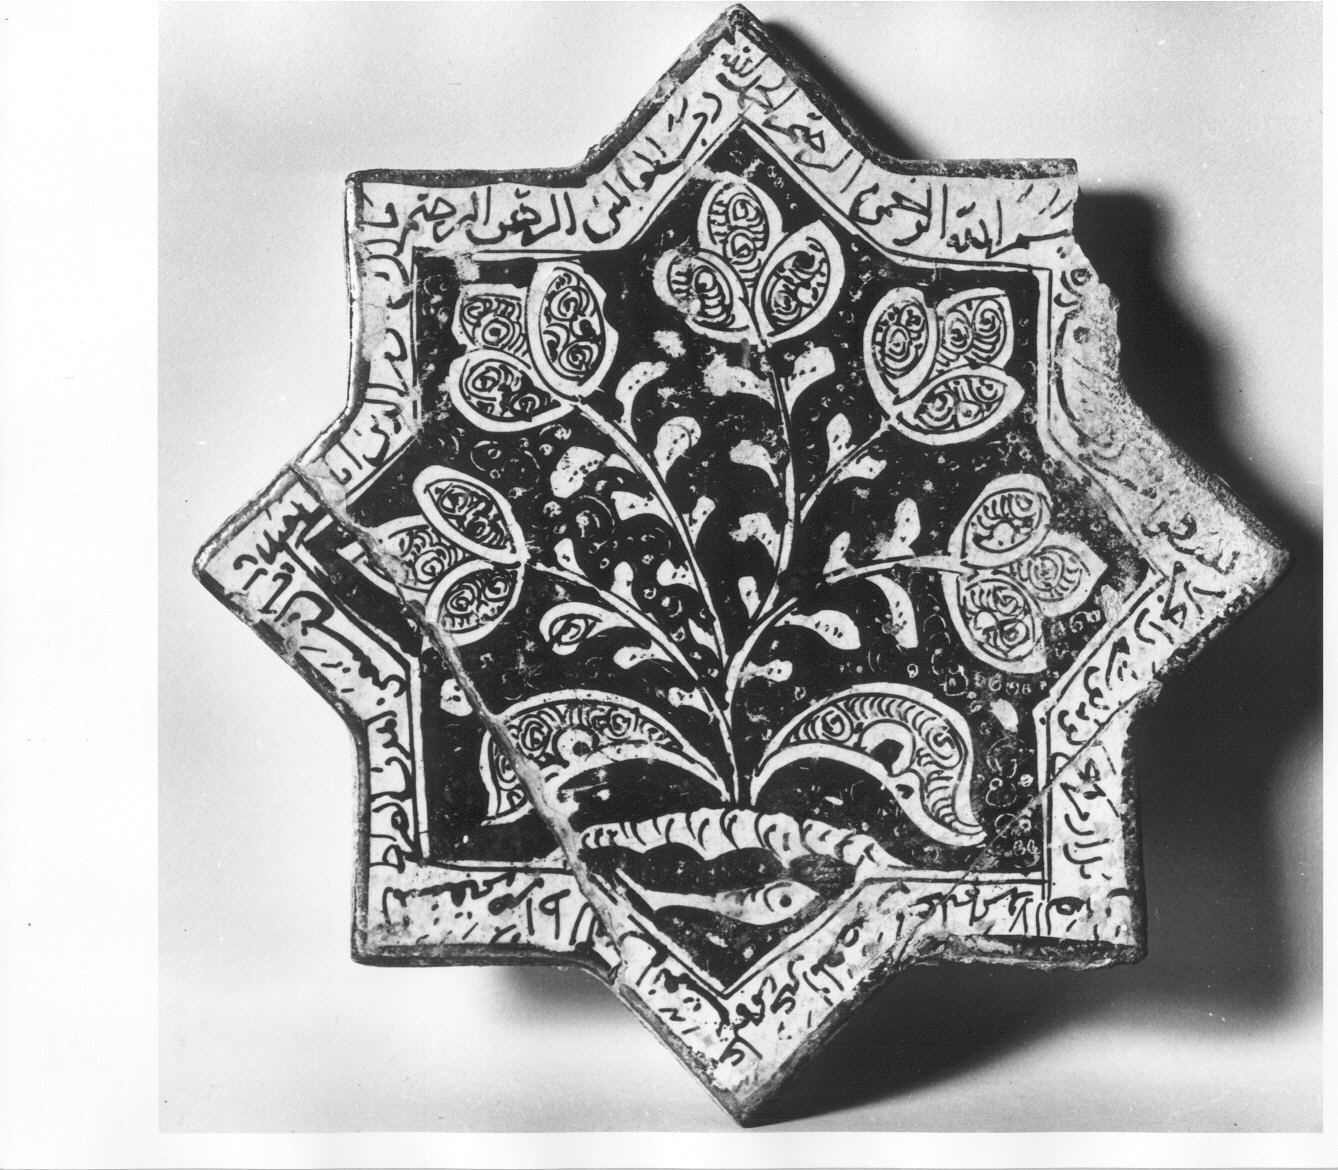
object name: tile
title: Star-Shaped Tile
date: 1201-1300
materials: cobalt, glaze, stonepaste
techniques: luster painting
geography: iran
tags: plants